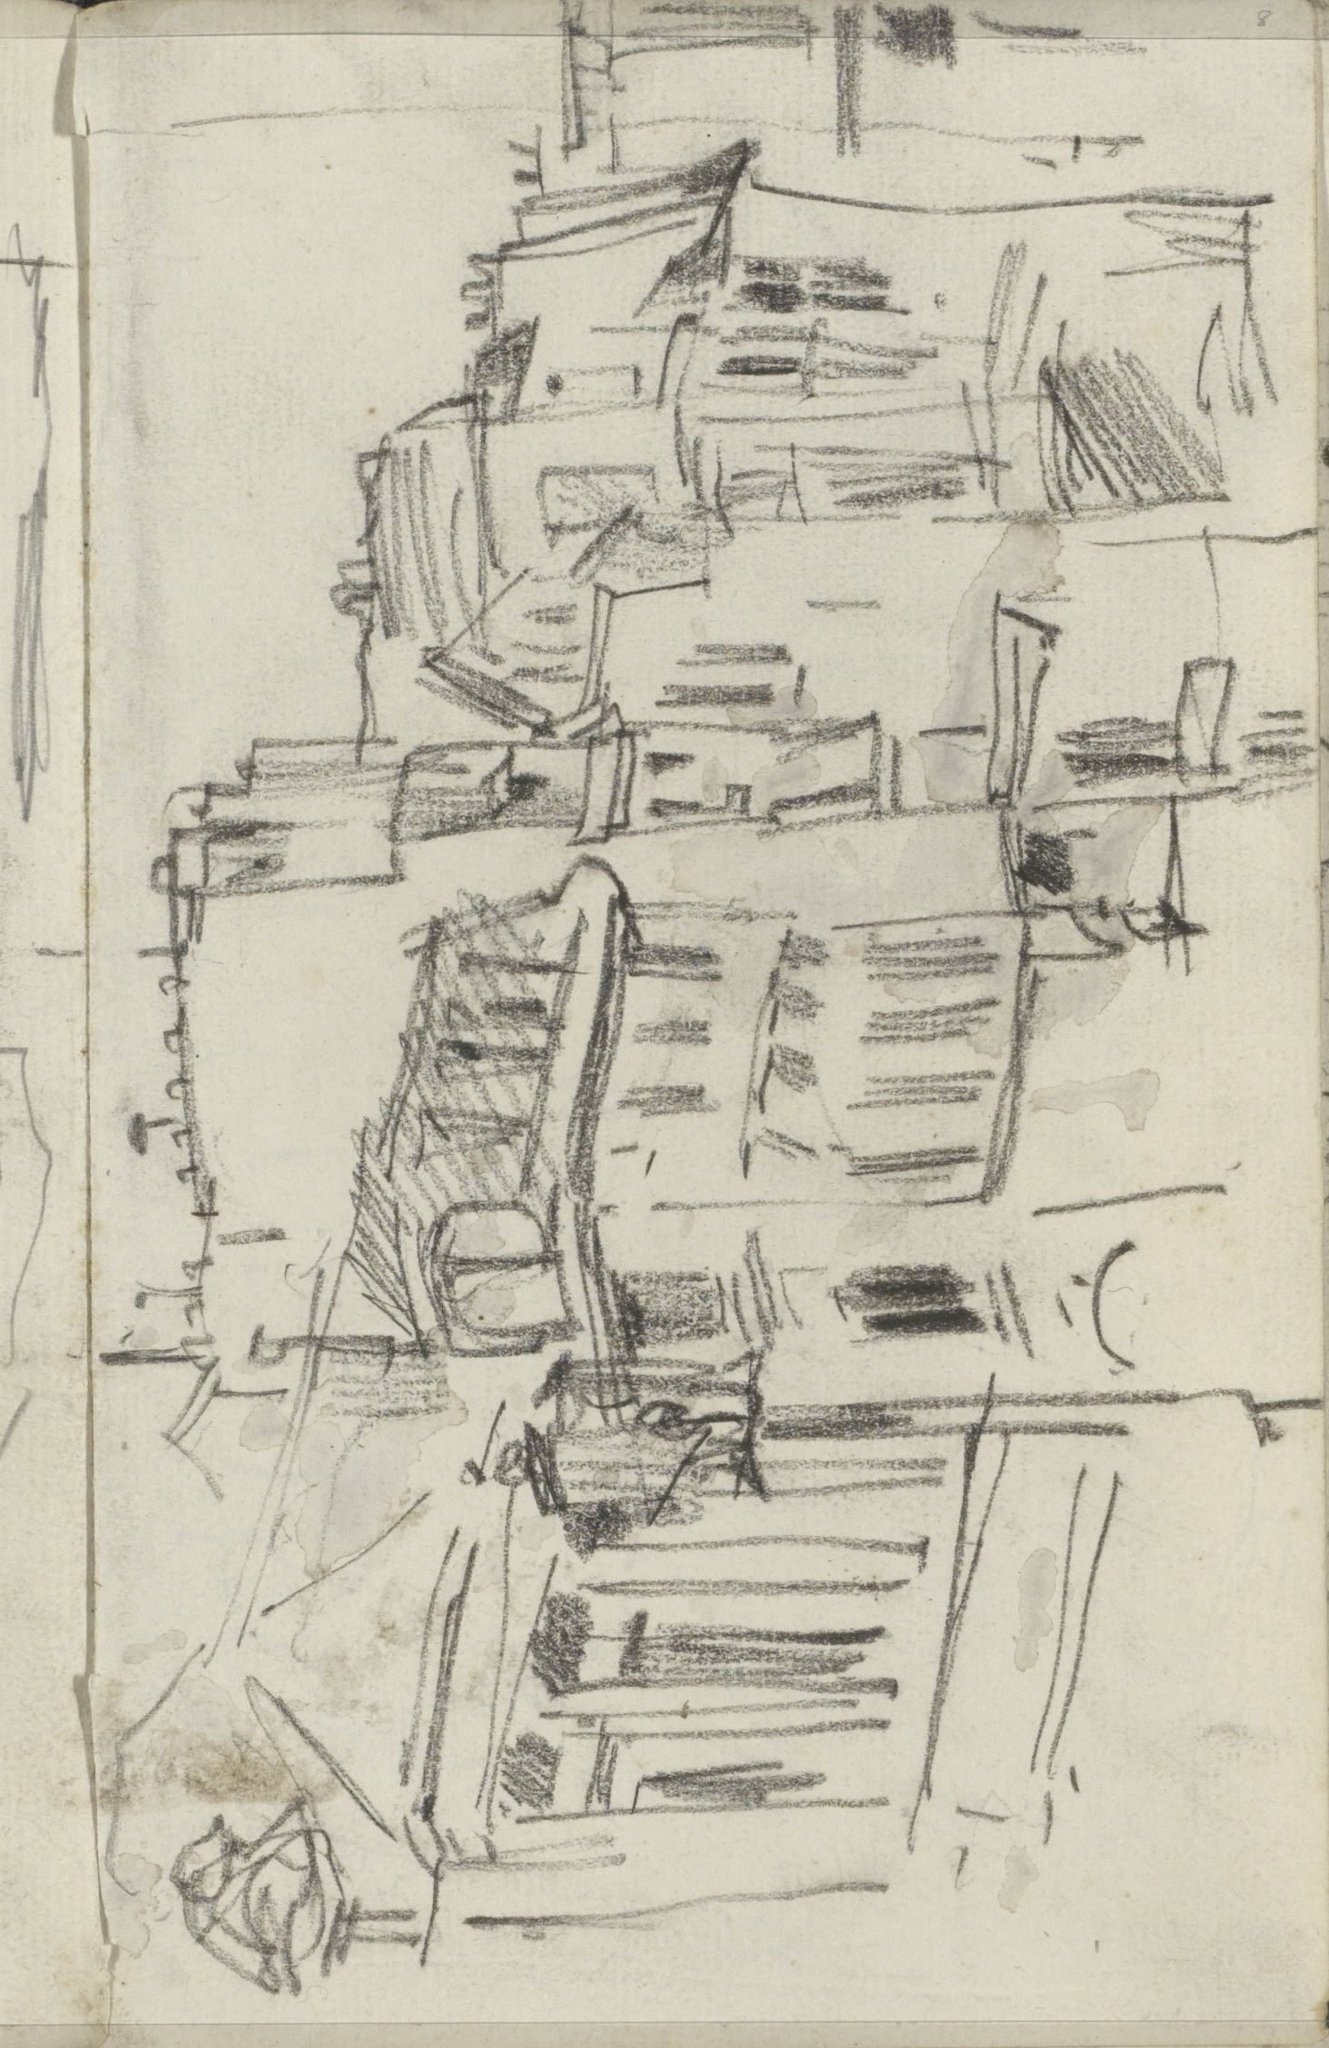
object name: sketchbook leaf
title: Gebouwen in Parijs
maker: george hendrik breitner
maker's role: draughtsman, painter, print maker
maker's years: 1857-1923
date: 1884-1886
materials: chalk, paper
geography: paris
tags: city-view, and landscape with man-made constructions, civic architecture; edifices; dwellings, paris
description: Pagina 8 uit een schetsboek met 25 bladen.